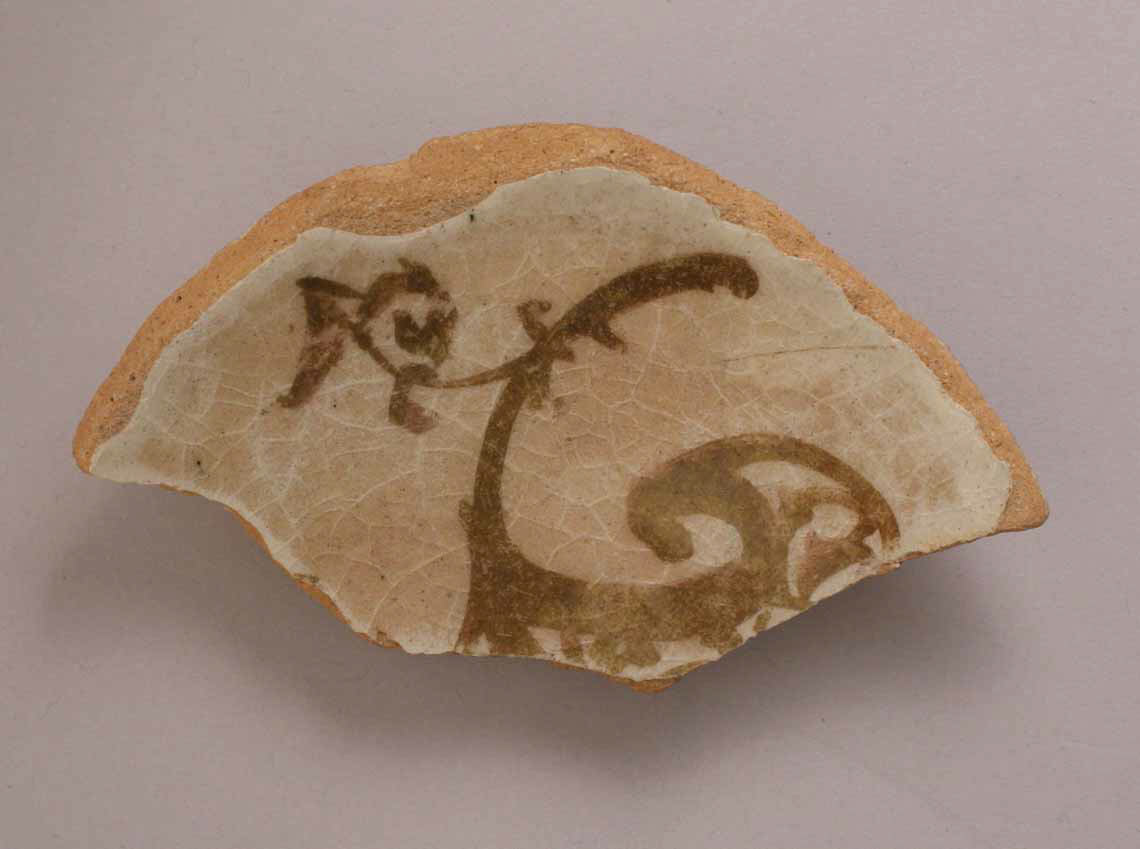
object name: fragment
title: Ceramic Fragment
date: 1001-1100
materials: earthenware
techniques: glazing, luster painting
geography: egypt